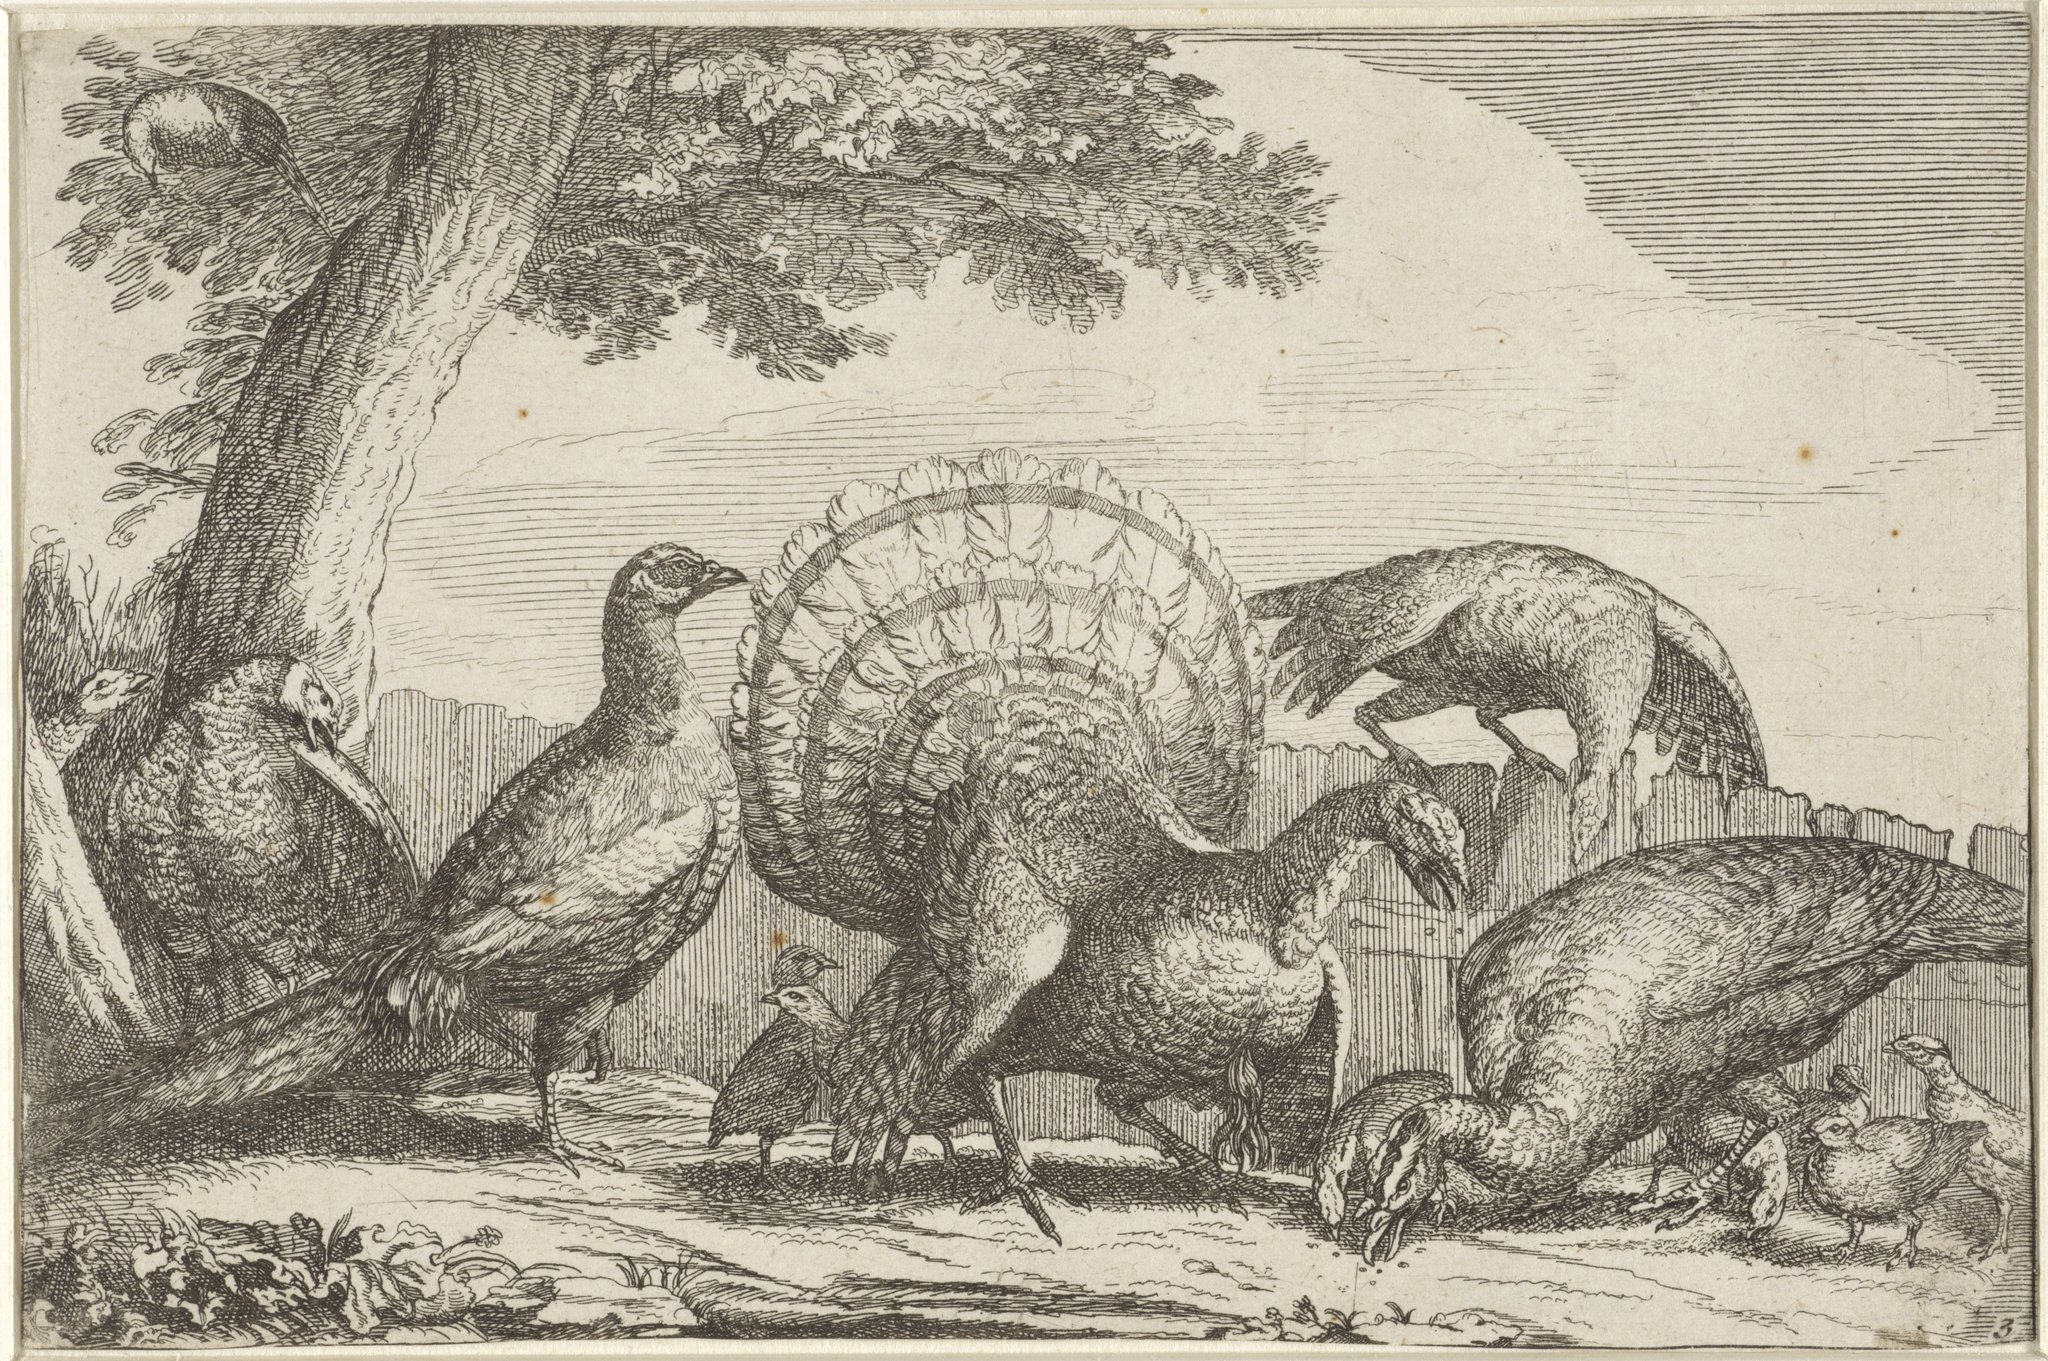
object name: print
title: Kalkoenen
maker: Anonymous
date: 1650-1750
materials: paper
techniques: etching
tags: walker and runner birds: turkey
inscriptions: collector's mark: Lugt 240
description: Vgl. serie "Diversae avium species", door Wenceslaus Hollar.